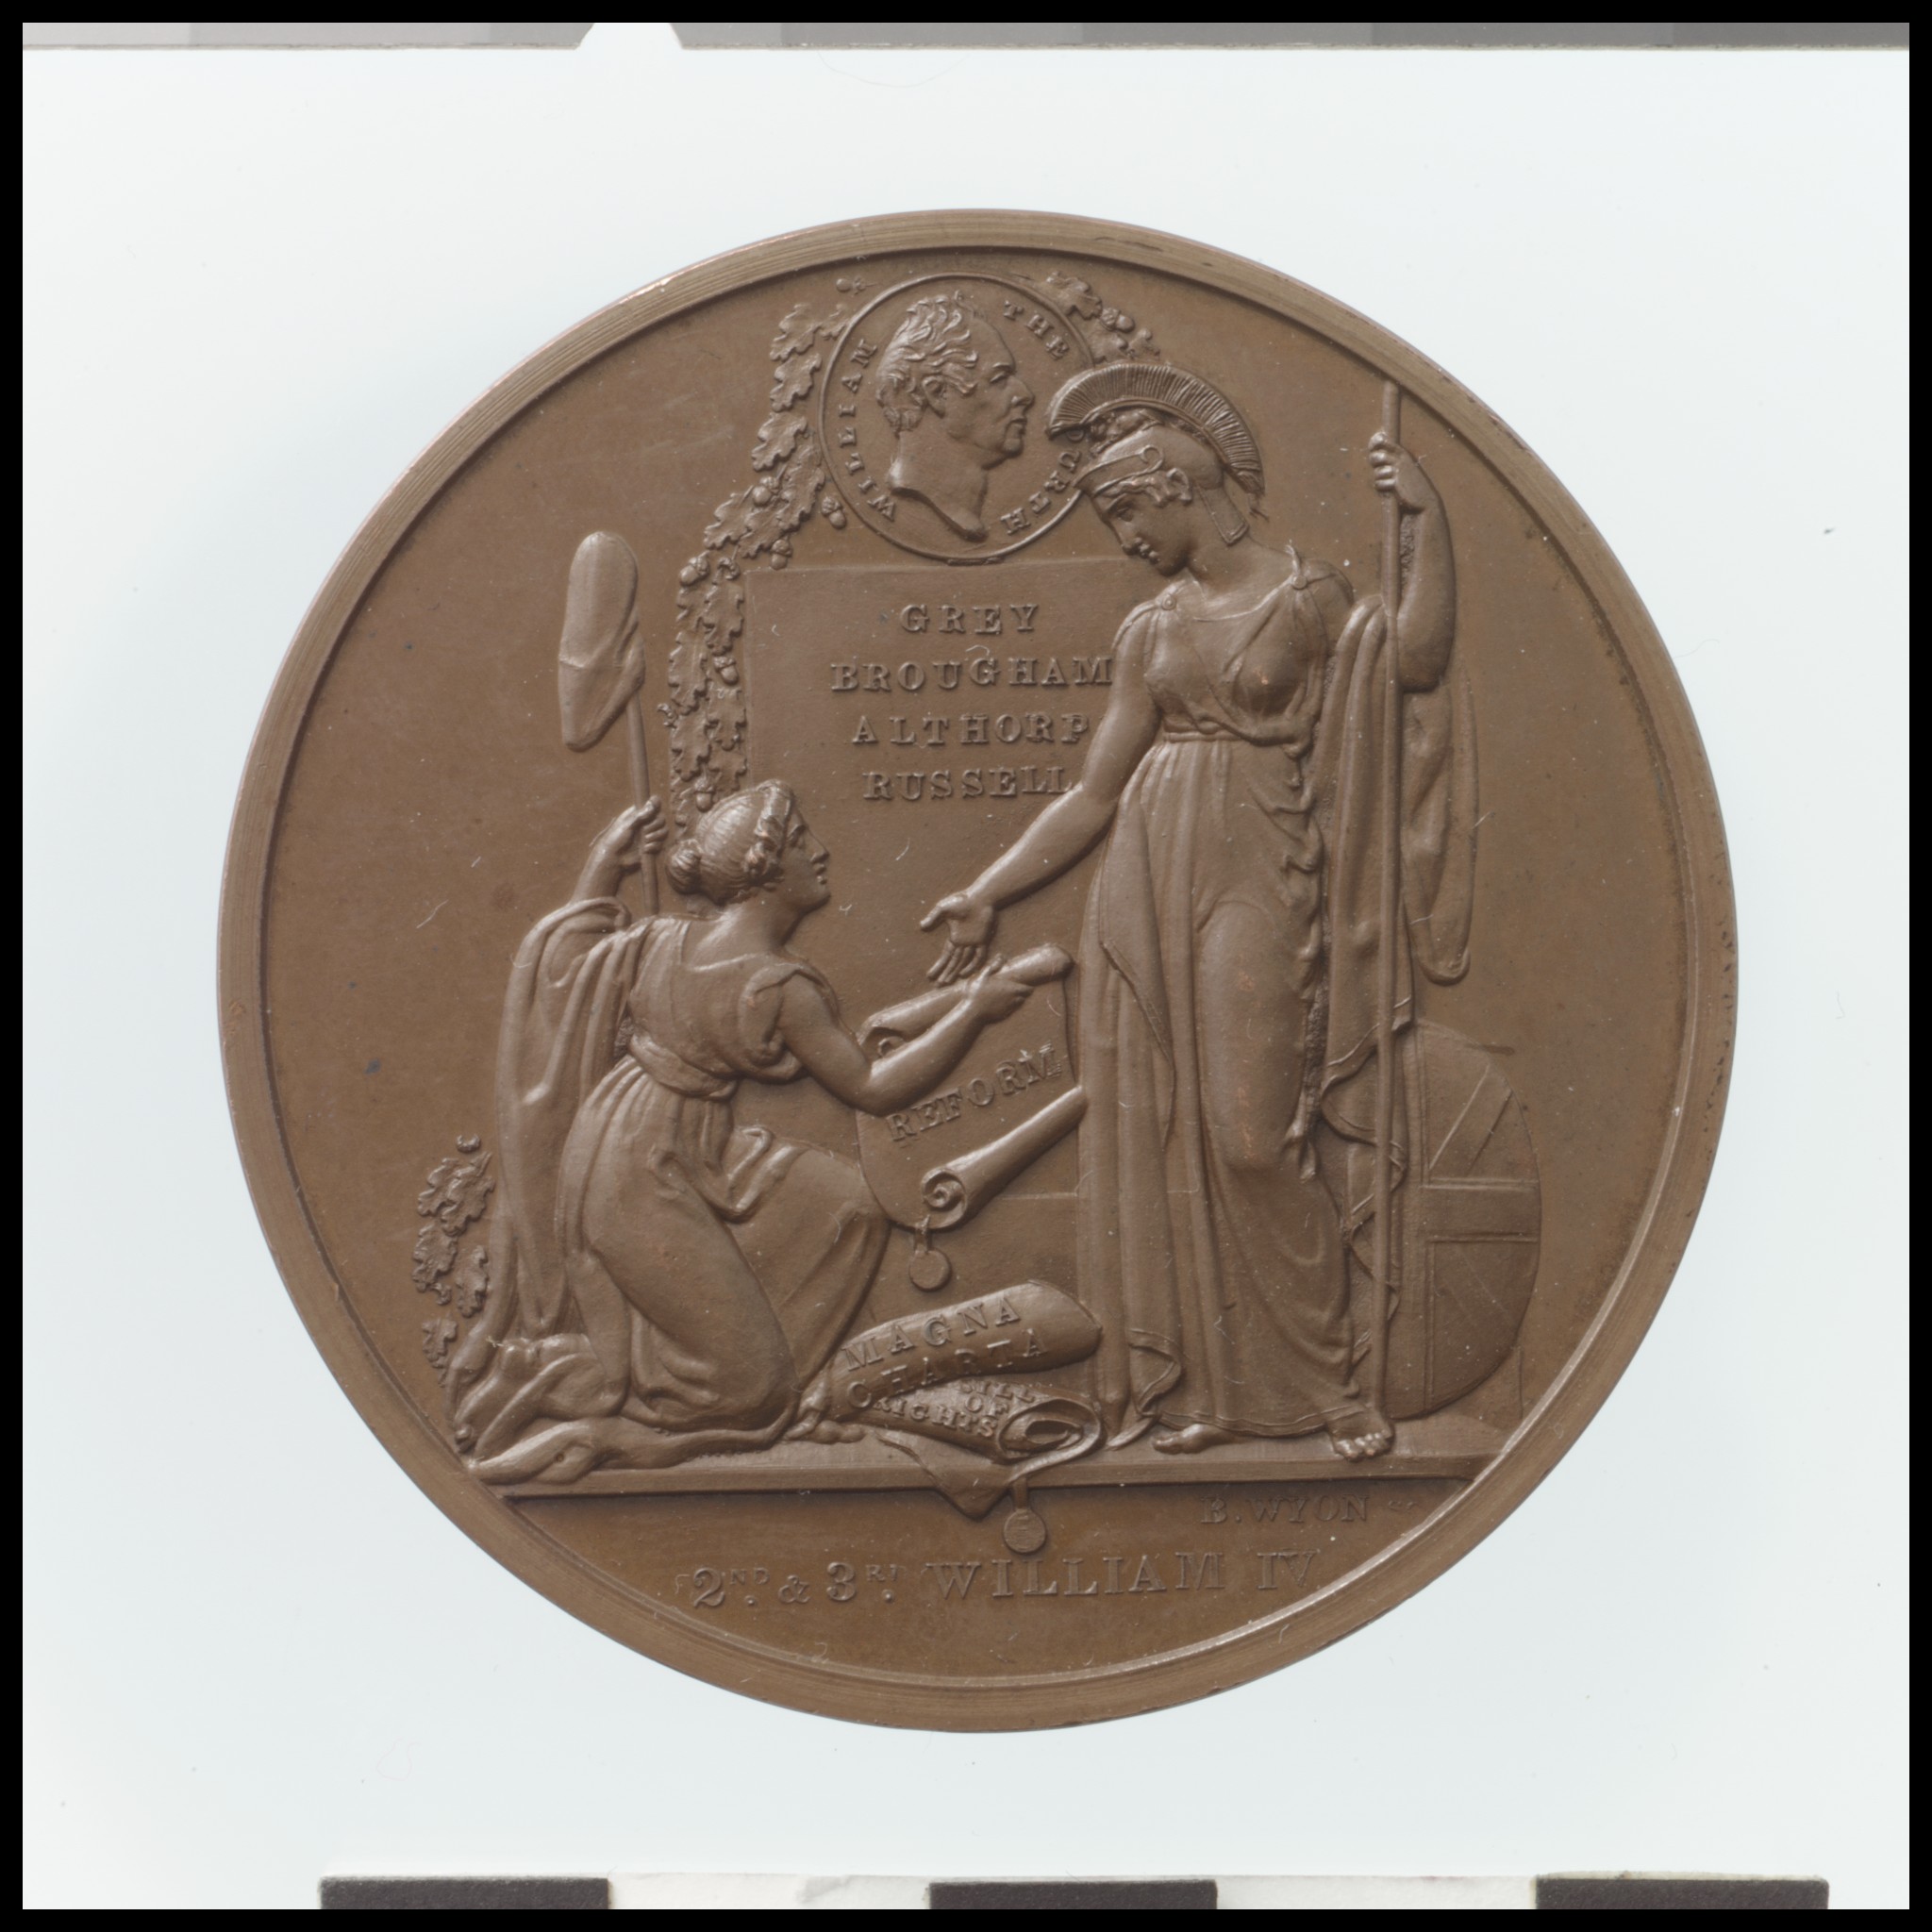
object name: medal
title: The Reform Bill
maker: benjamin wyon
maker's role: maker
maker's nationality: british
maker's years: 1802-1858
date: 1832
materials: bronze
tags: men,profiles,women,coat of arms